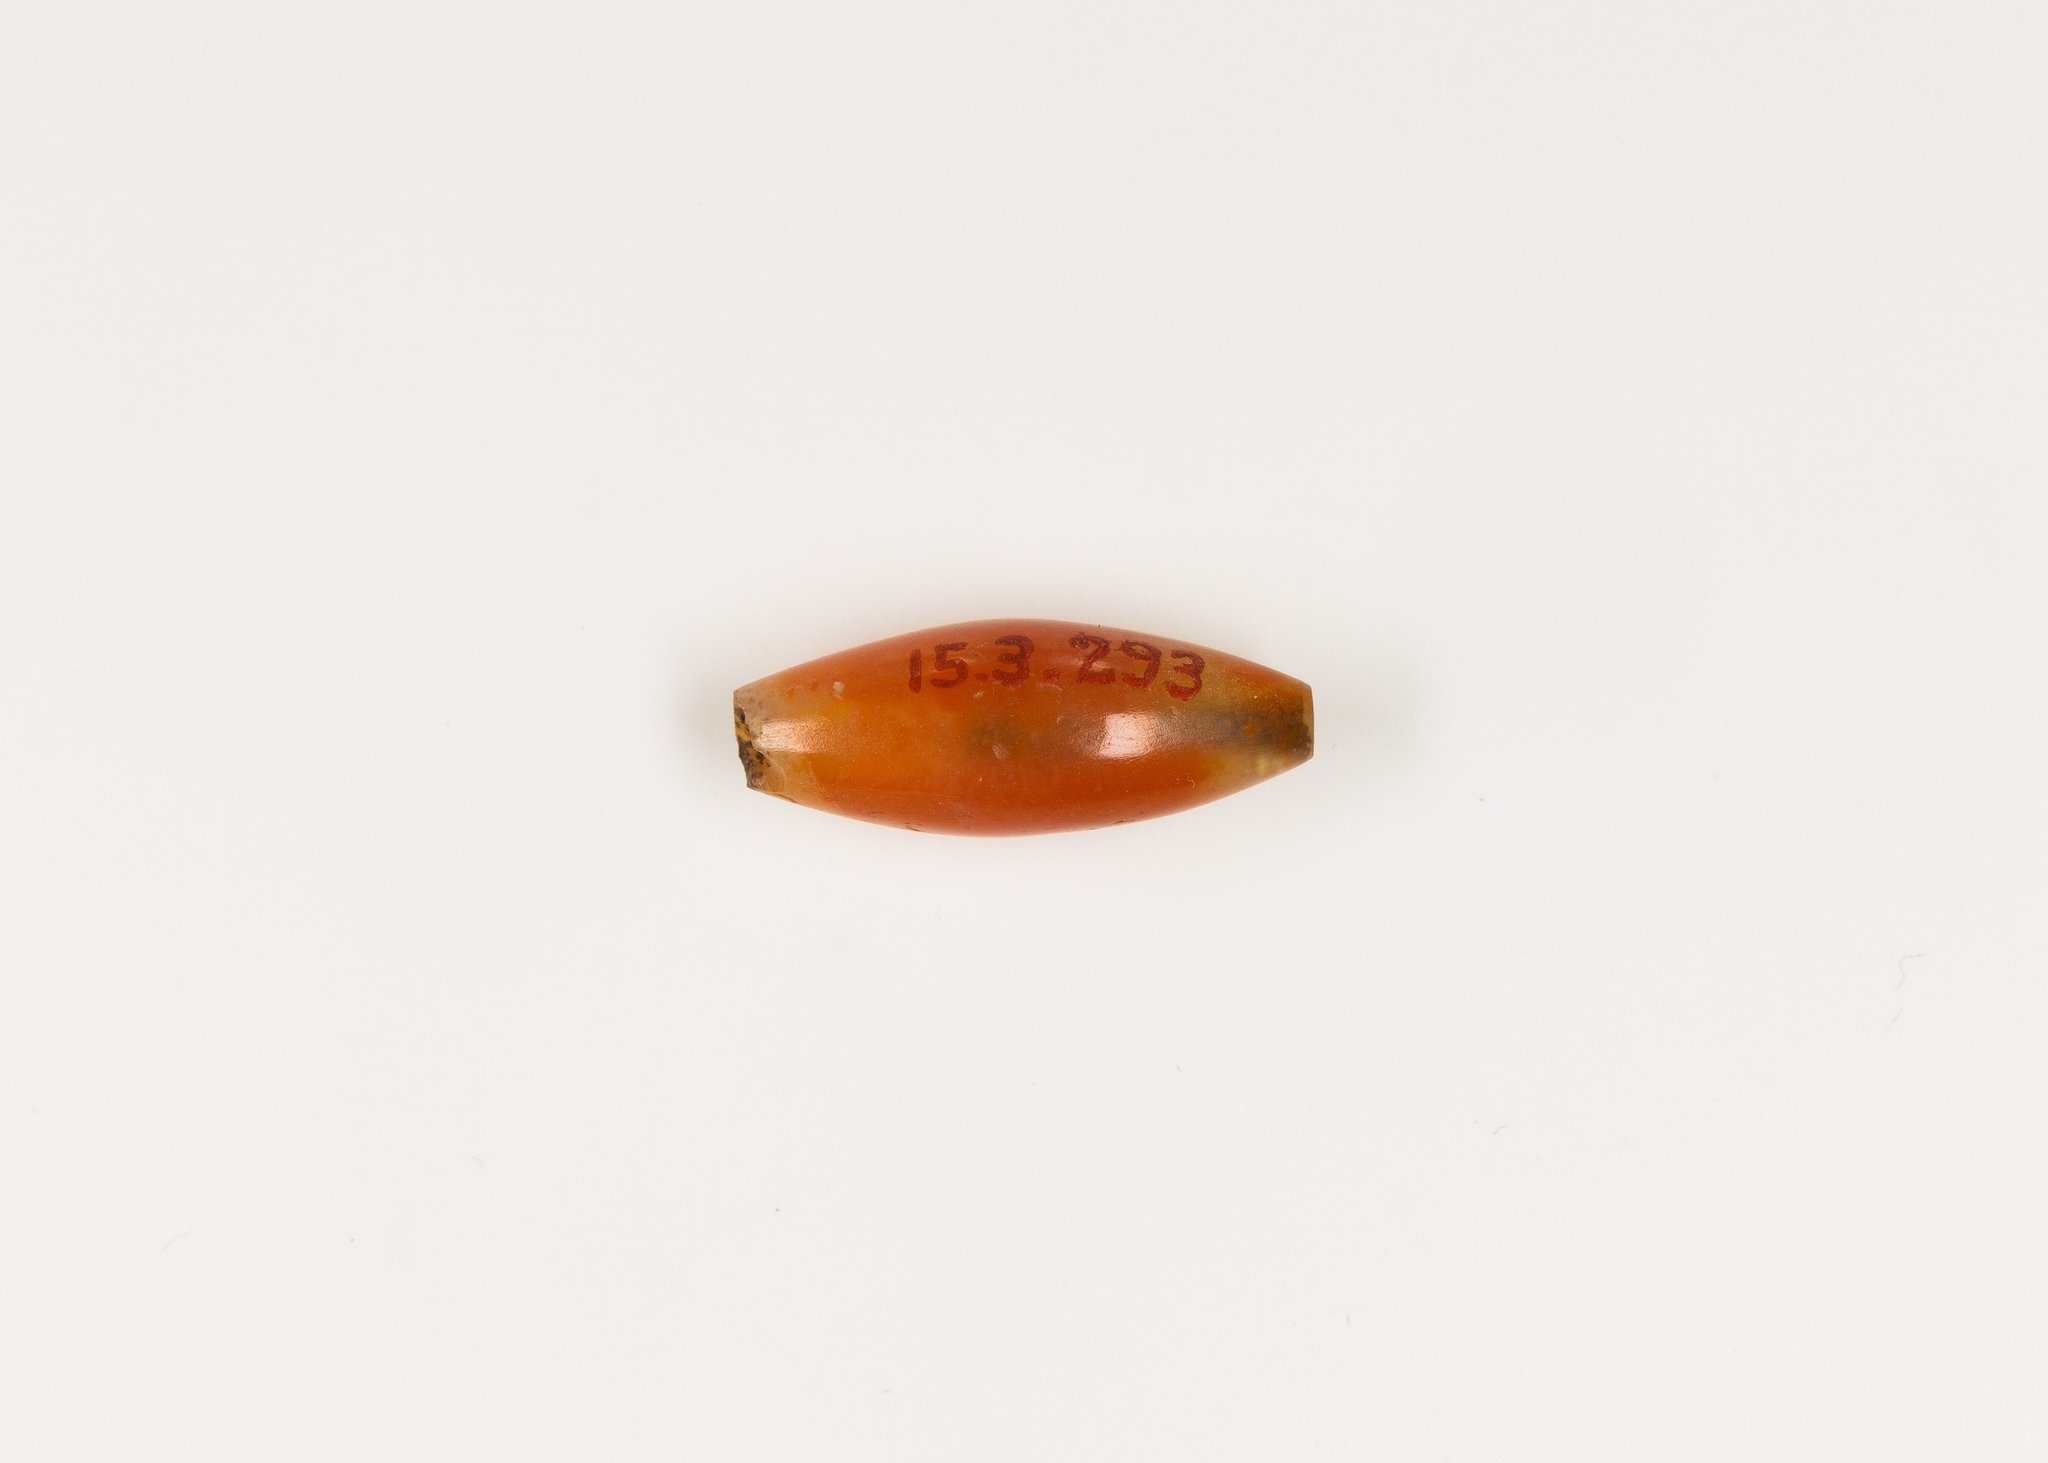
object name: bead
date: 1850-1750 BCE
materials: gemstone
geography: egypt